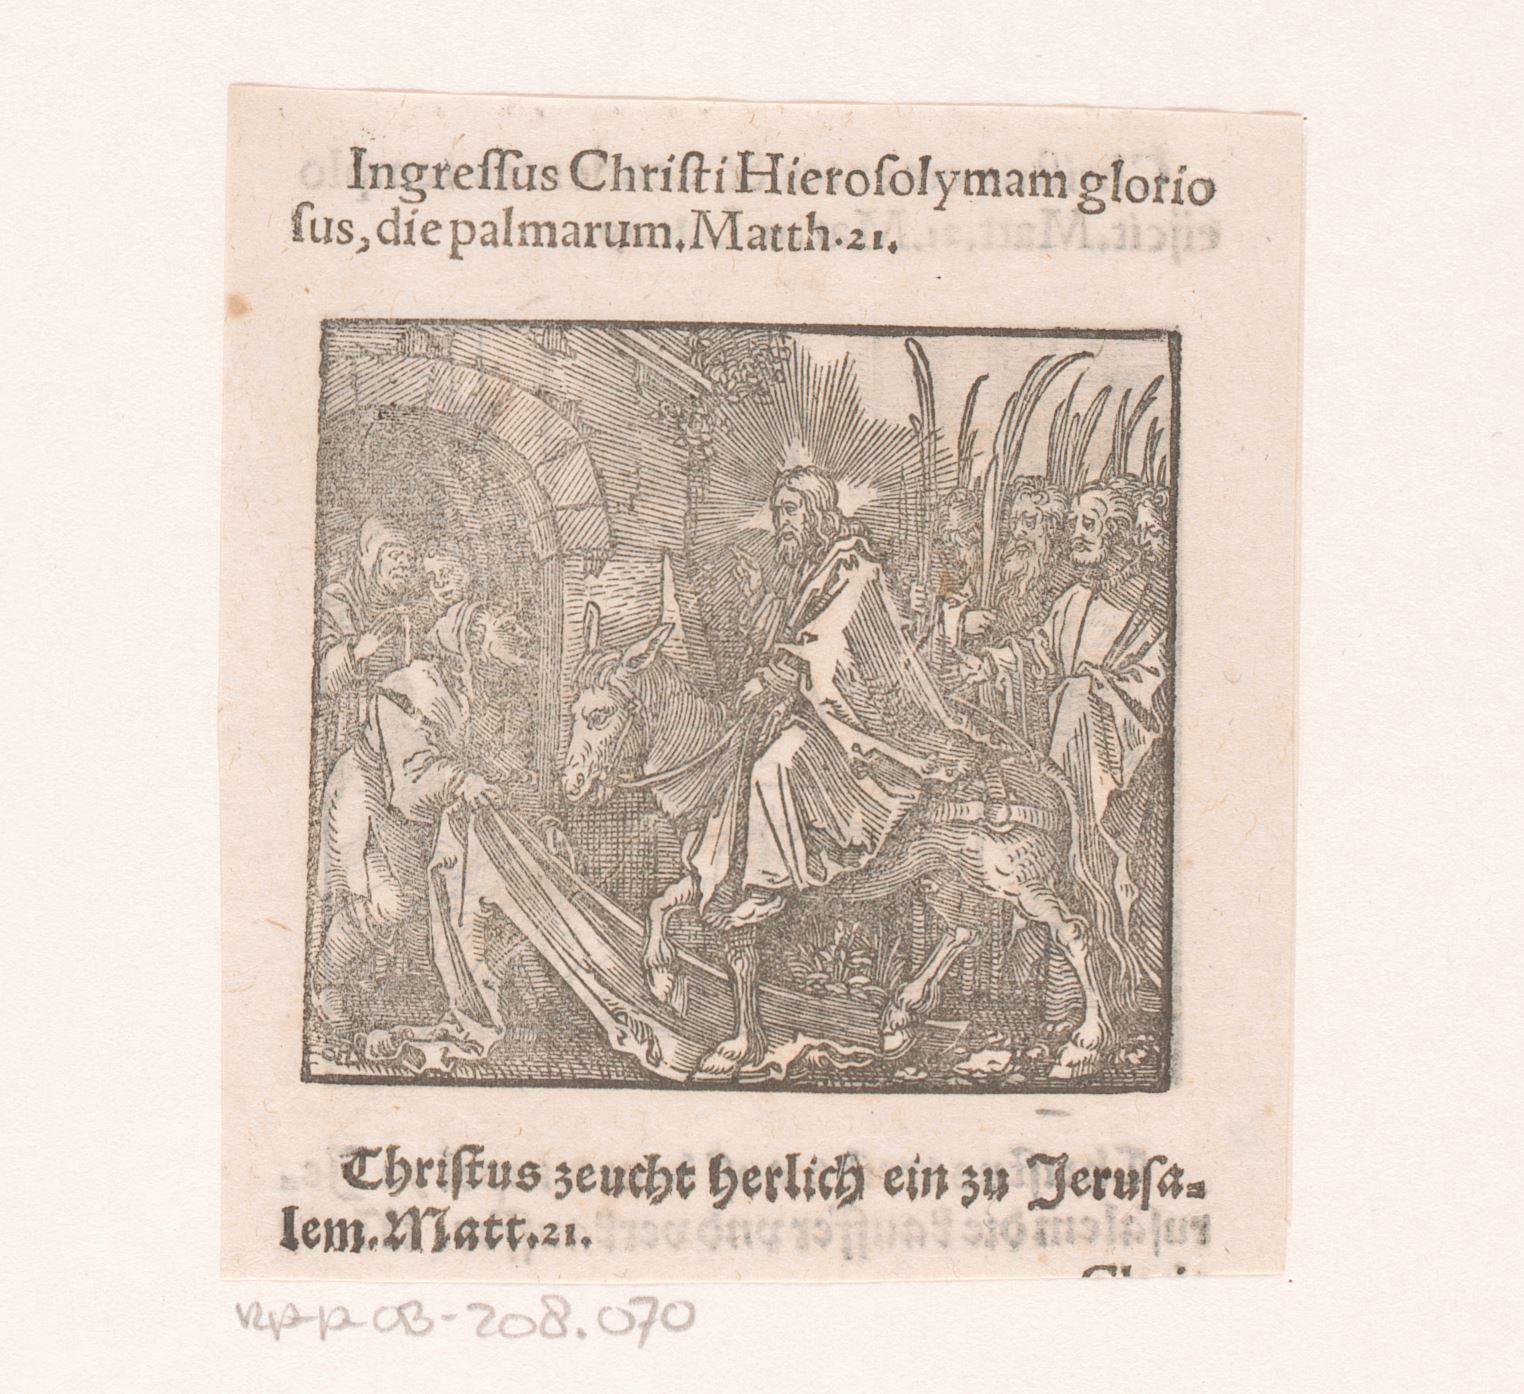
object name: print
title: Intocht van Christus in Jeruzalem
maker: Anonymous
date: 1600-1699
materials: paper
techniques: letterpress printing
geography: netherlands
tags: entry into jerusalem: people spreading their clothes before christ on the ass, and waving palm branches (matthew 21:1-11, 21:14-16; mark 11:1-11; luke 19:28-40; john 12:12-19)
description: Christus rijdt op een ezel Jeruzalem binnen. De menigte zwaait met palmtakken en legt kleden en mantels voor hem op de grond.